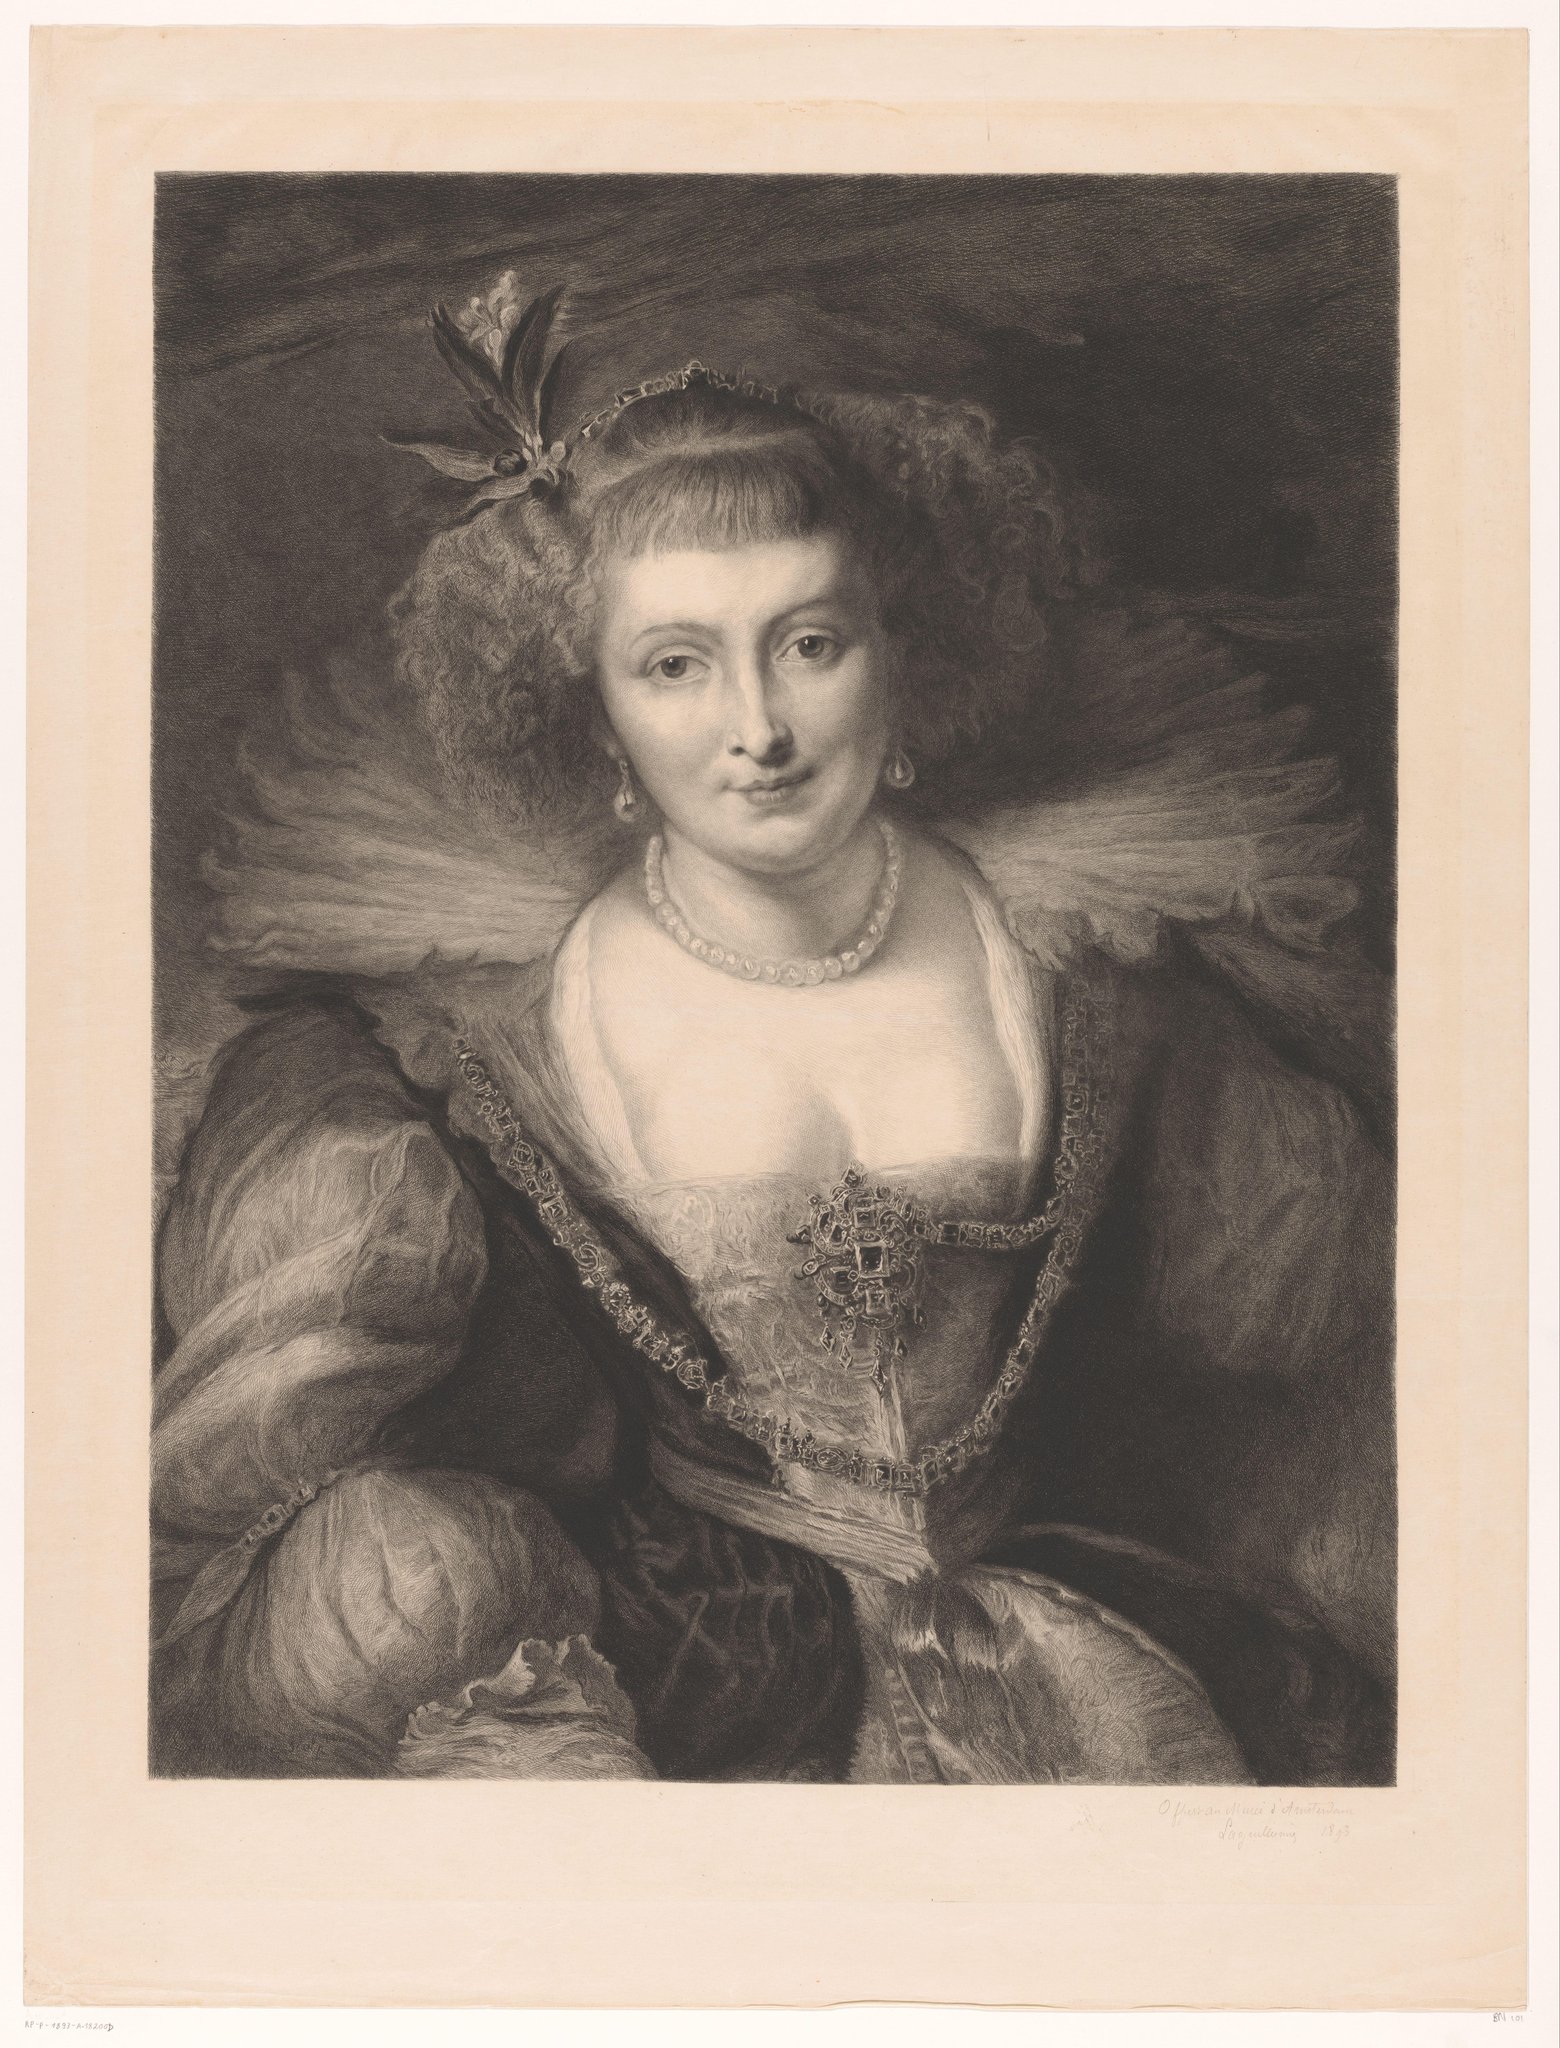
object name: print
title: Portret van Hélène Fourment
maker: frédéric auguste la guillermie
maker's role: print maker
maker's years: 1841-1934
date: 1892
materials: paper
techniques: drypoint, engraving, etching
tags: antwerp, historical persons - bb - woman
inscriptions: collector's mark: Lugt 2228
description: Het schilderij waarop de prentmaker zich baseerde, bevindt zich eveneens in de collectie van het Rijksmuseum. Zie hiervoor objectnummer SK-C-295.